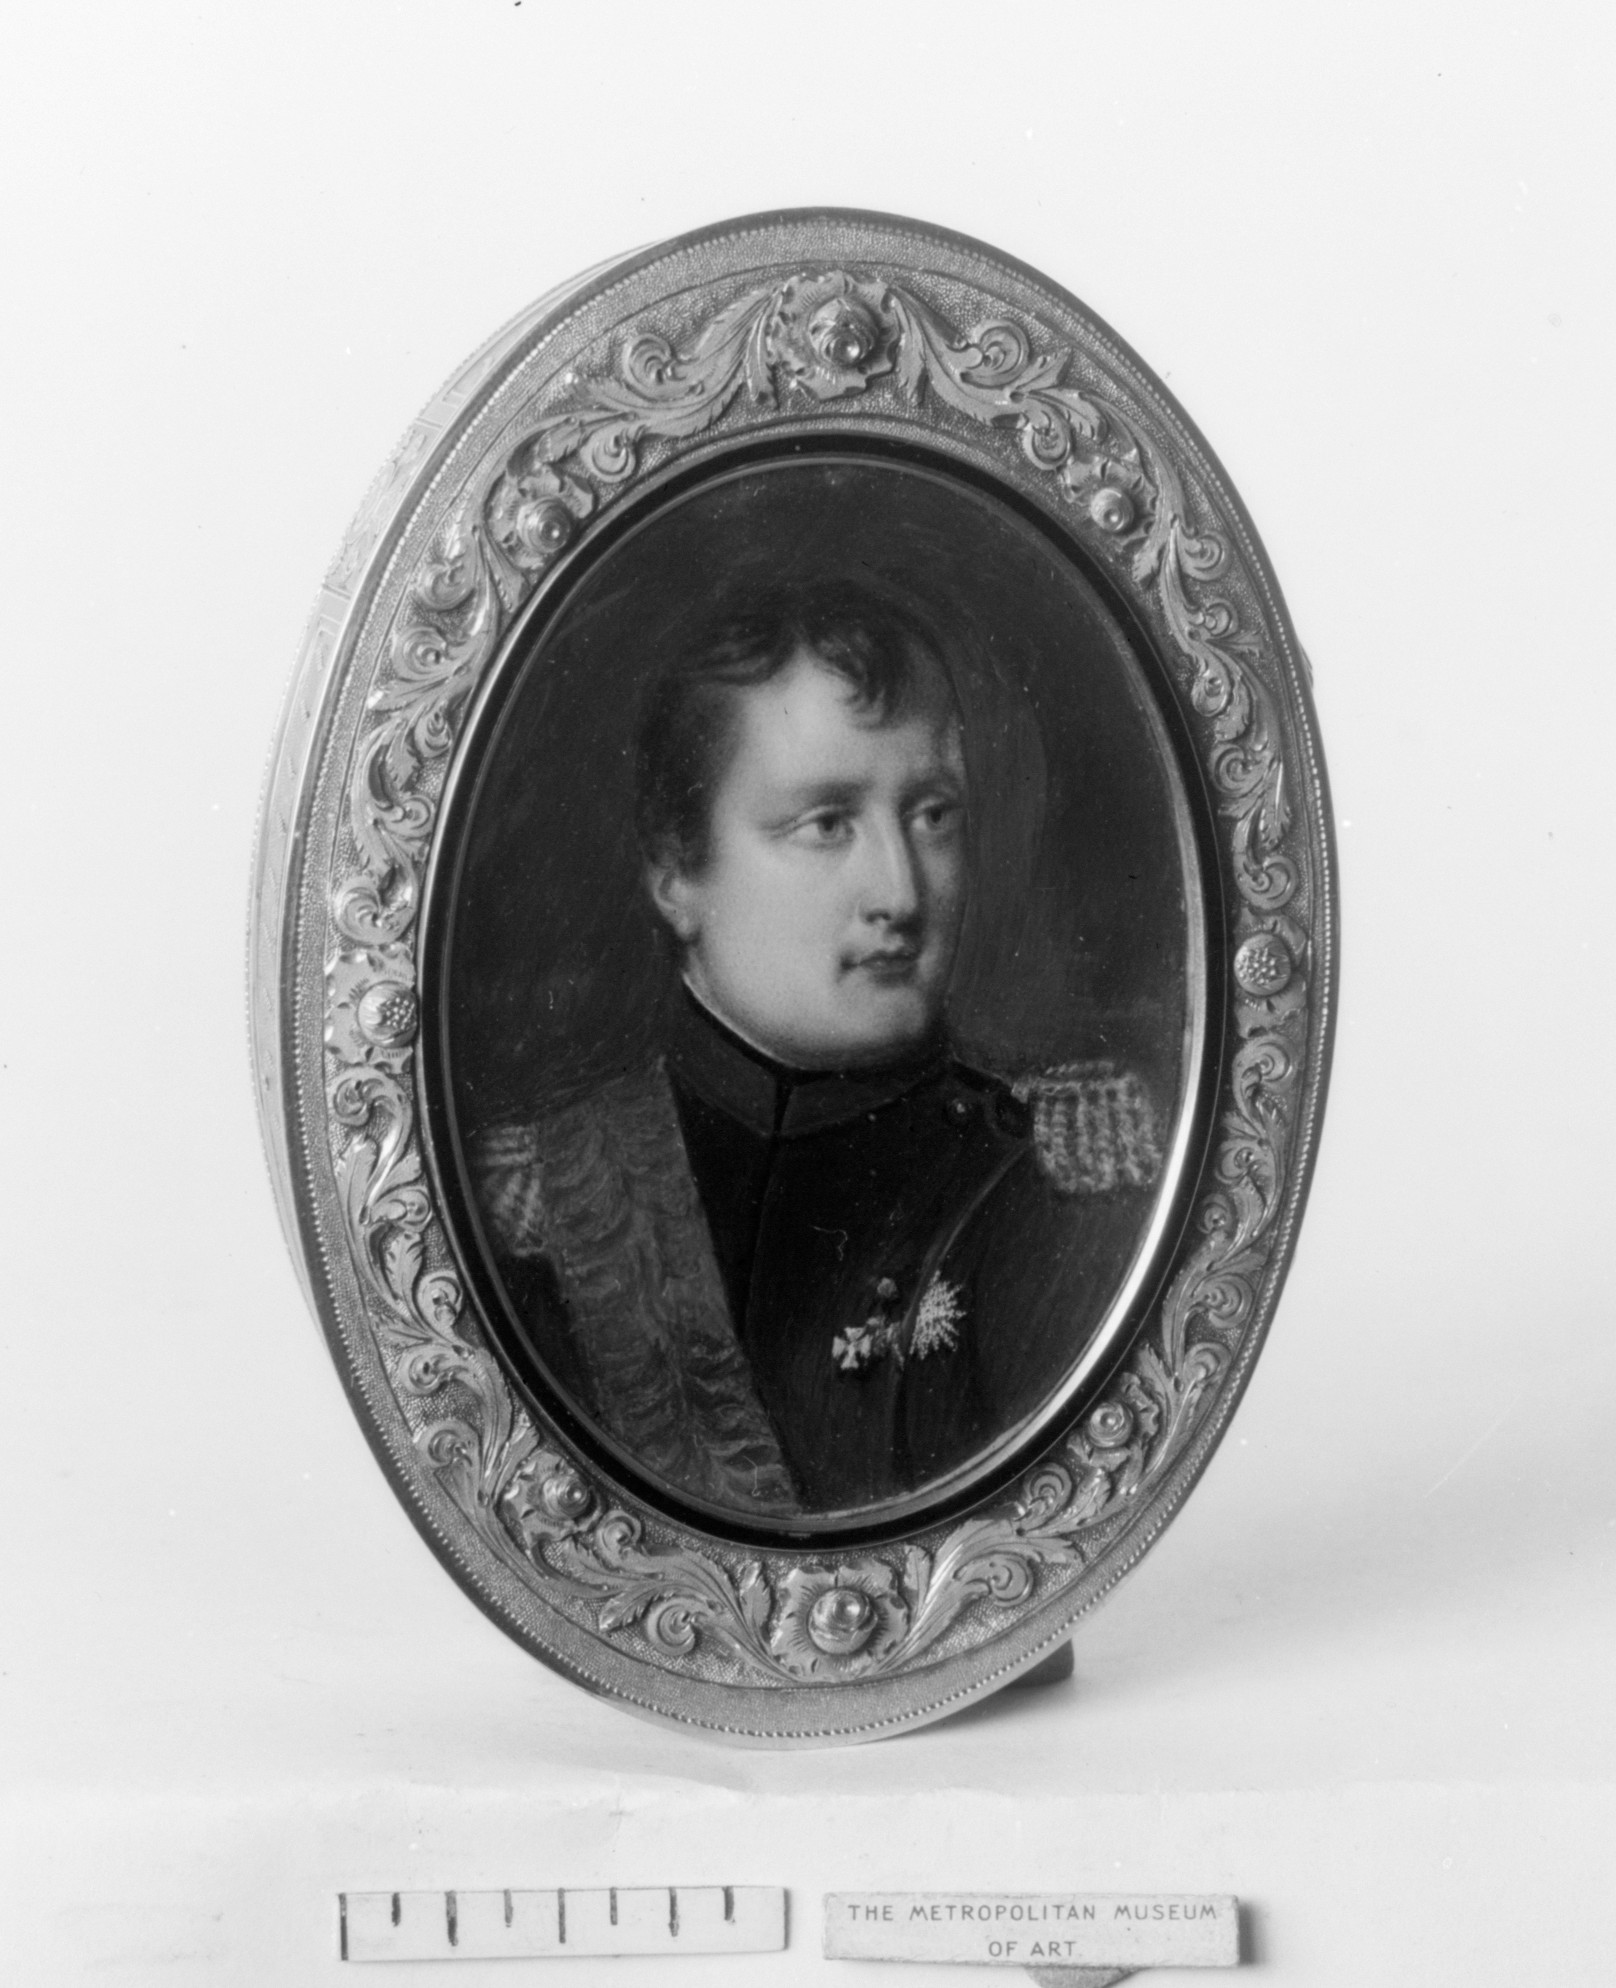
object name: snuffbox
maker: victoire boisot (widow of etienne lucien blerzy)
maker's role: maker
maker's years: 1779-1840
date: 1810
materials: enamel, gold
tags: men,portraits